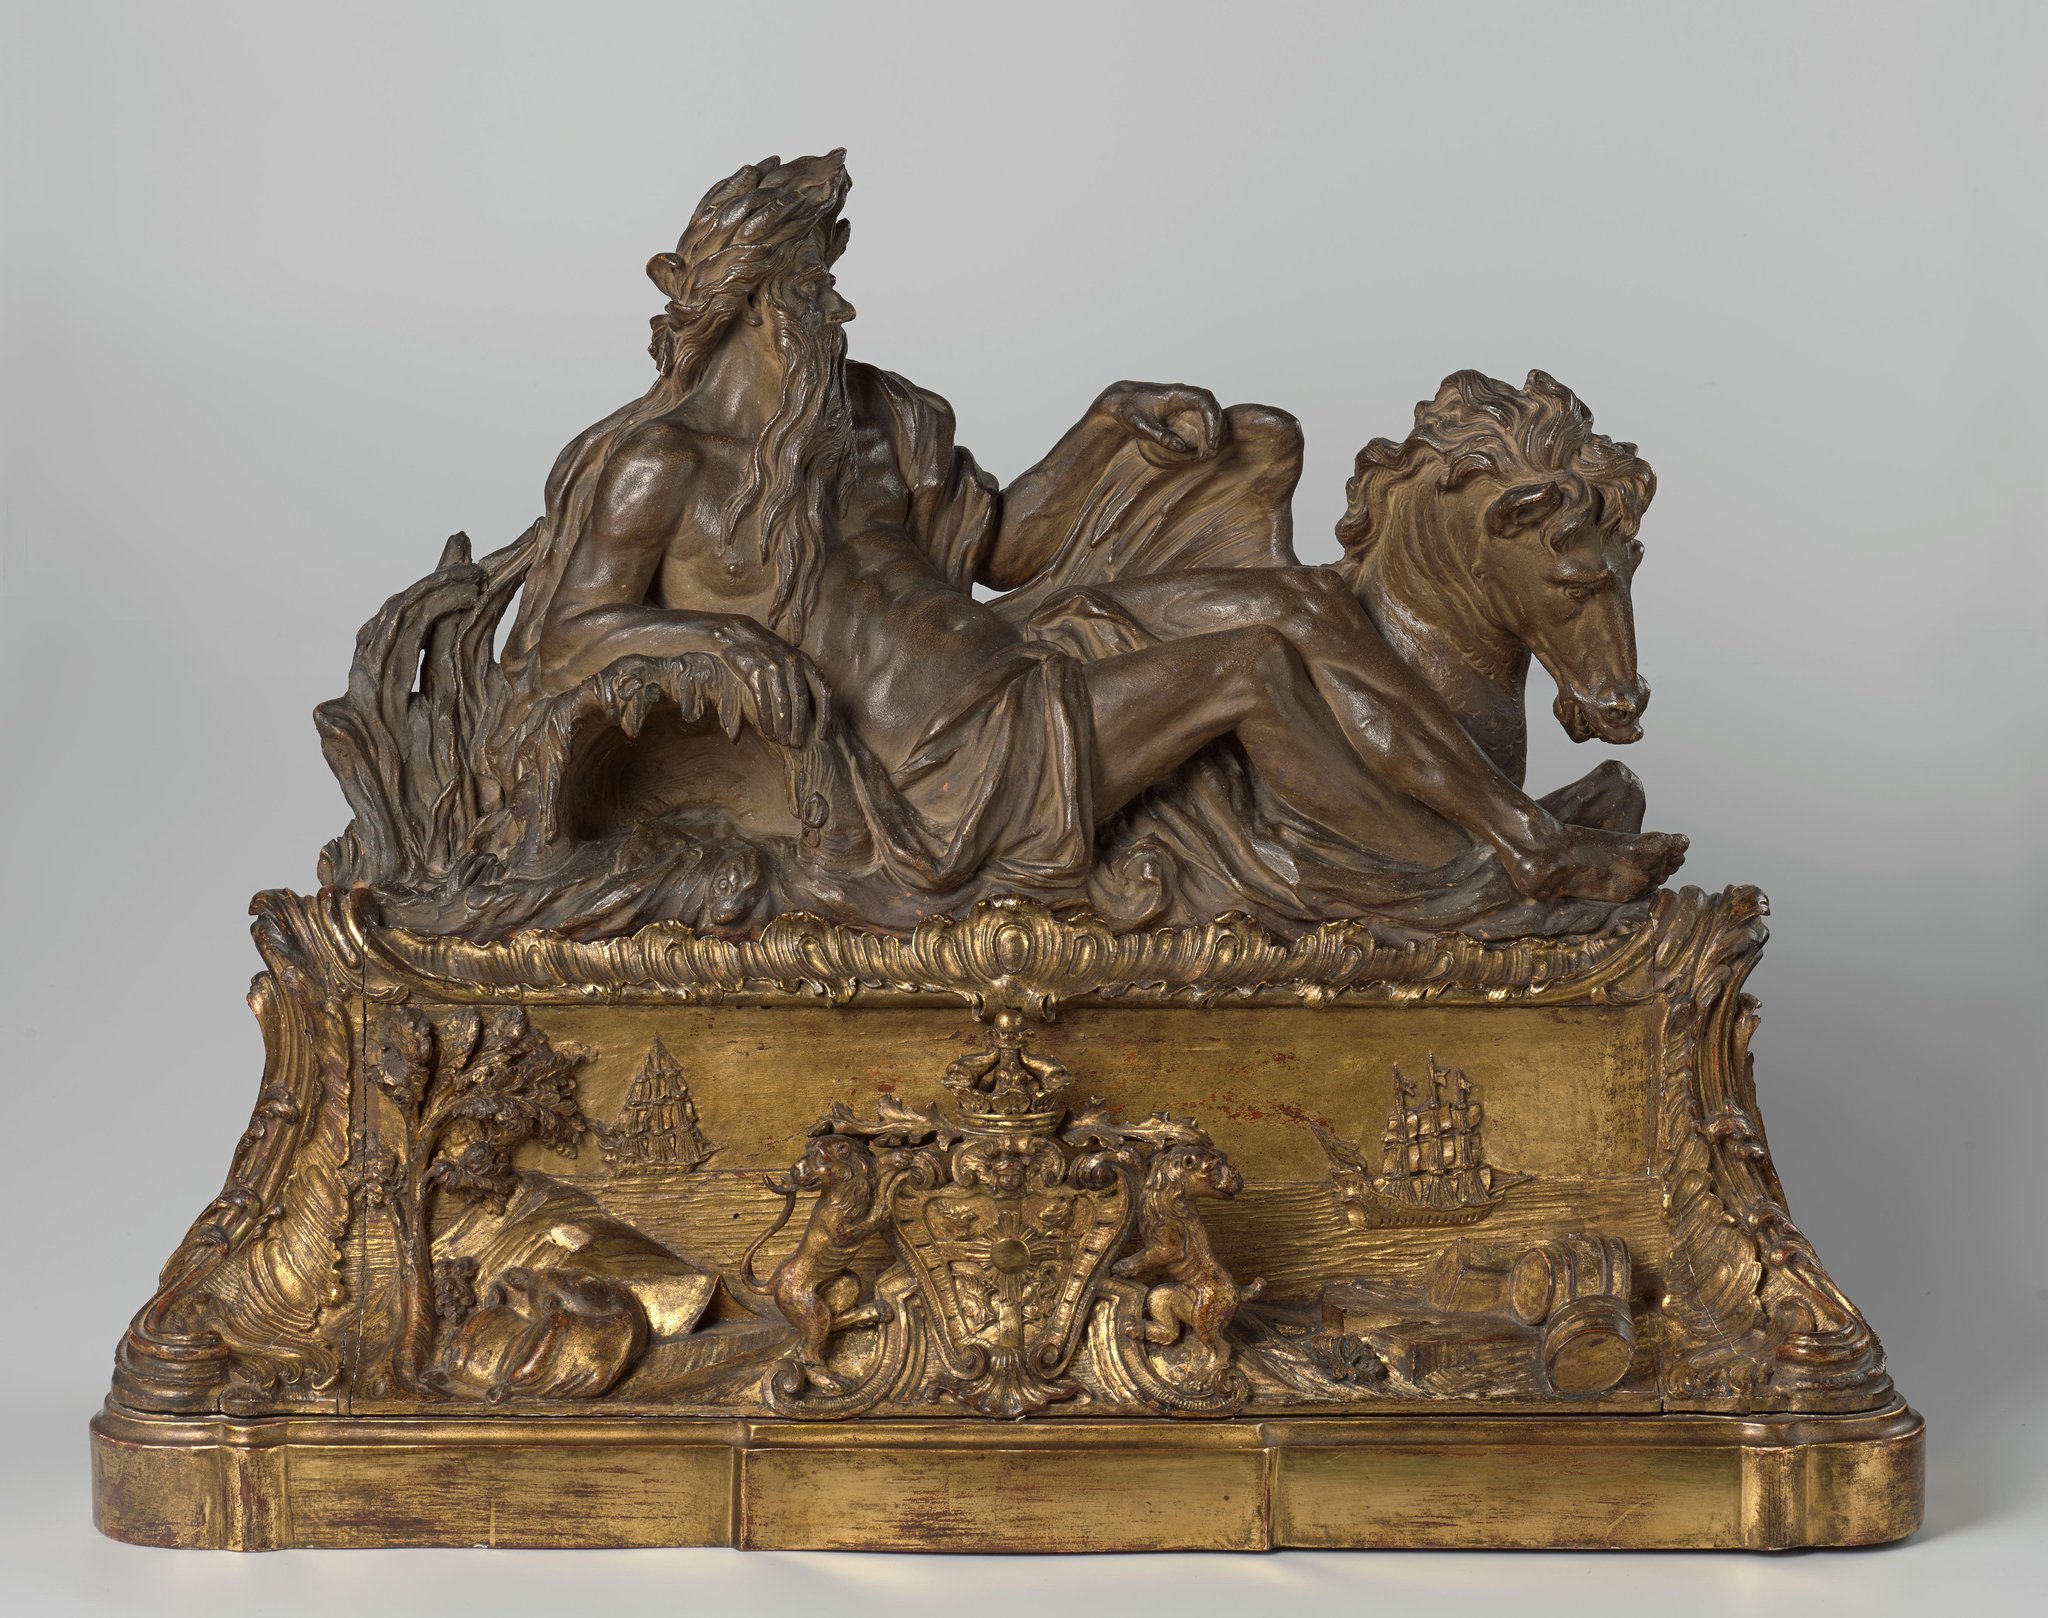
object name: pedestal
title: Voetstuk van Neptunus met zeepaard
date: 1670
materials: terracotta, wood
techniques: modeling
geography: leiden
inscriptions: signature: ‘PX’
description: Op het voetstuk zijn schepen op zee, aangespoelde tonnen en kisten afgebeeld. Het voetstuk is niet gesigneerd en is er later bij gemaakt door een onbekende beeldhouwer.